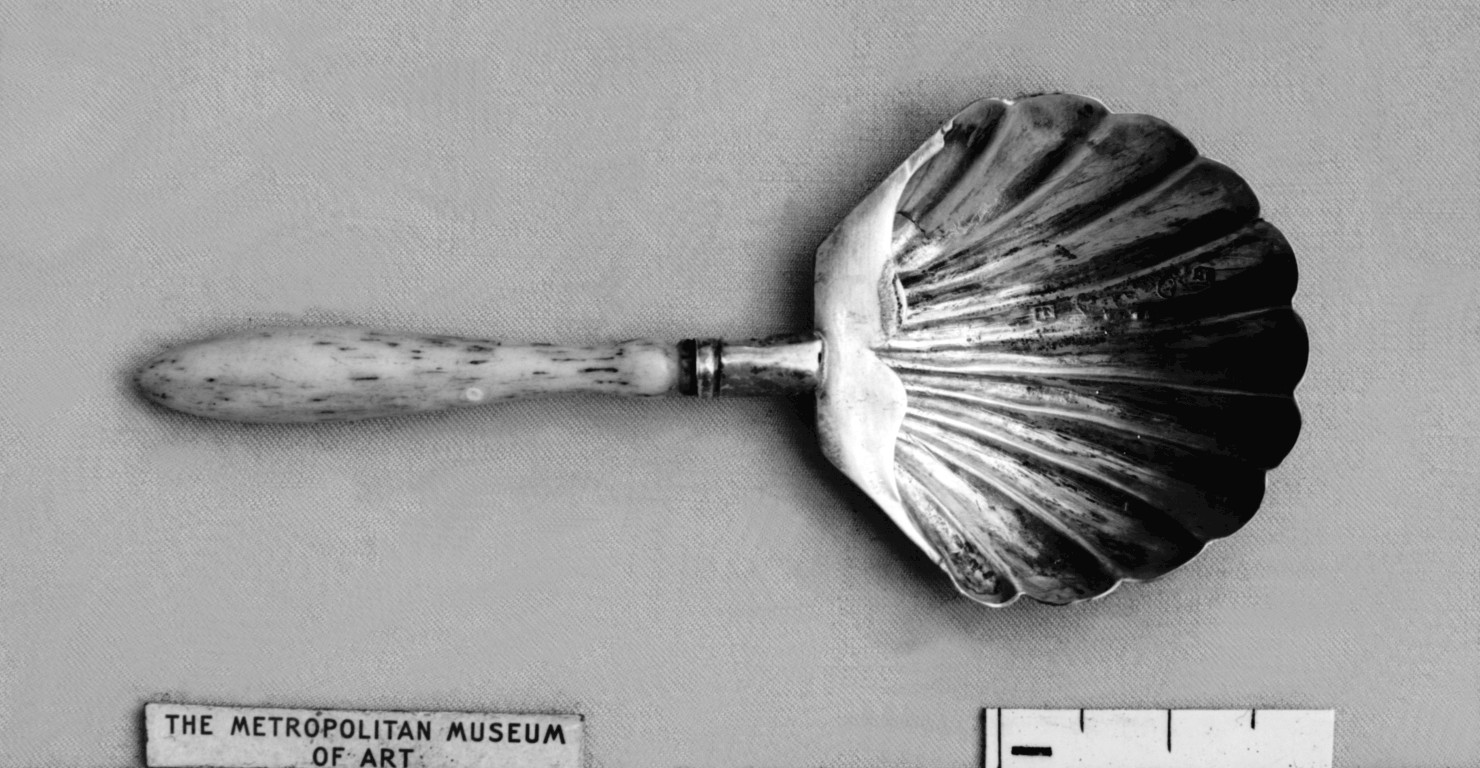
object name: caddy spoon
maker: j. l., birmingham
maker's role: maker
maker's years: 1811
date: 1811-1812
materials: ivory, silver